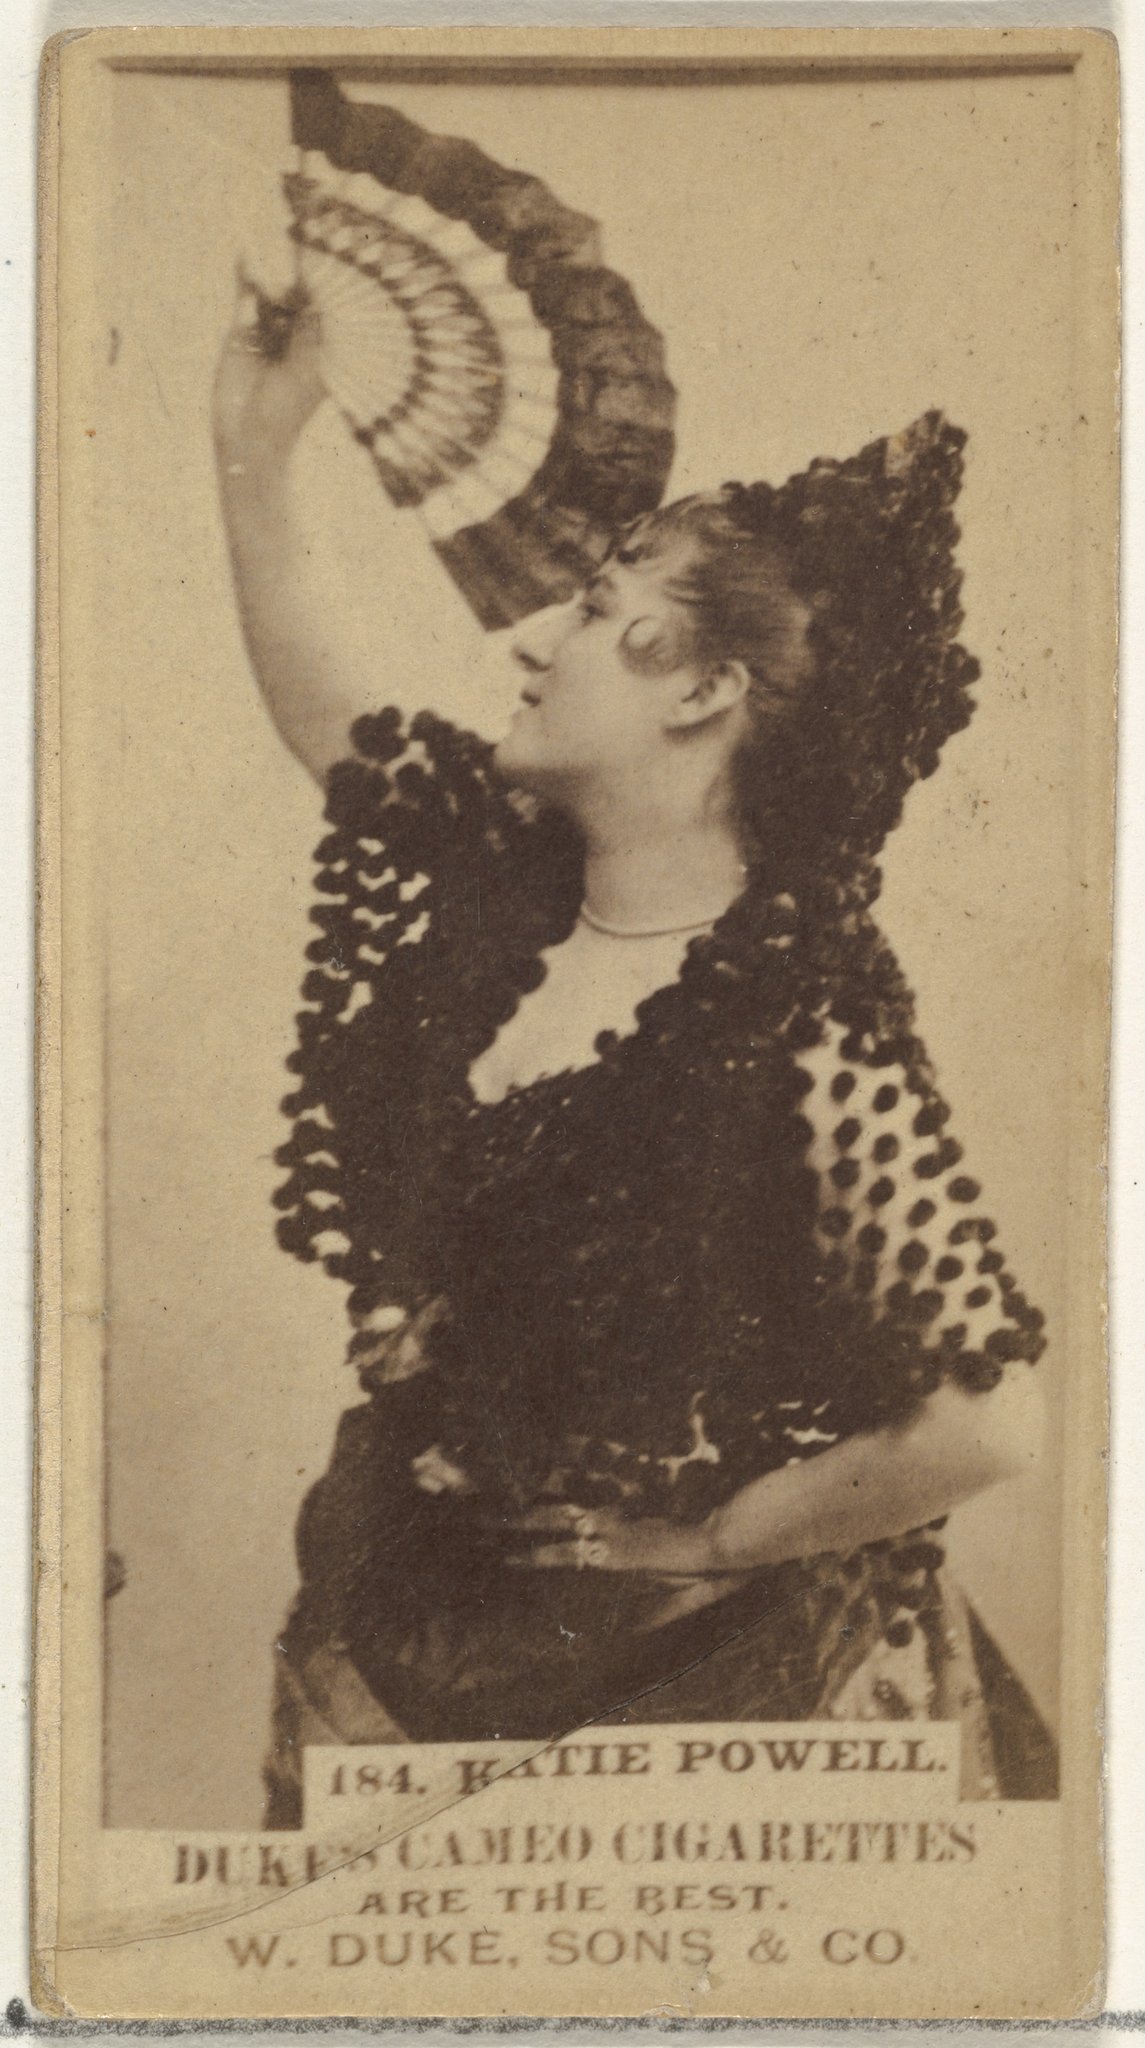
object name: photograph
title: Card Number 184, Katie Powell, from the Actors and Actresses series (N145-5) issued by Duke Sons & Co. to promote Cameo Cigarettes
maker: w. duke, sons & co.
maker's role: publisher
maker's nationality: american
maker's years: 1870-1920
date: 1880-1889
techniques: albumen silver print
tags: women,actresses